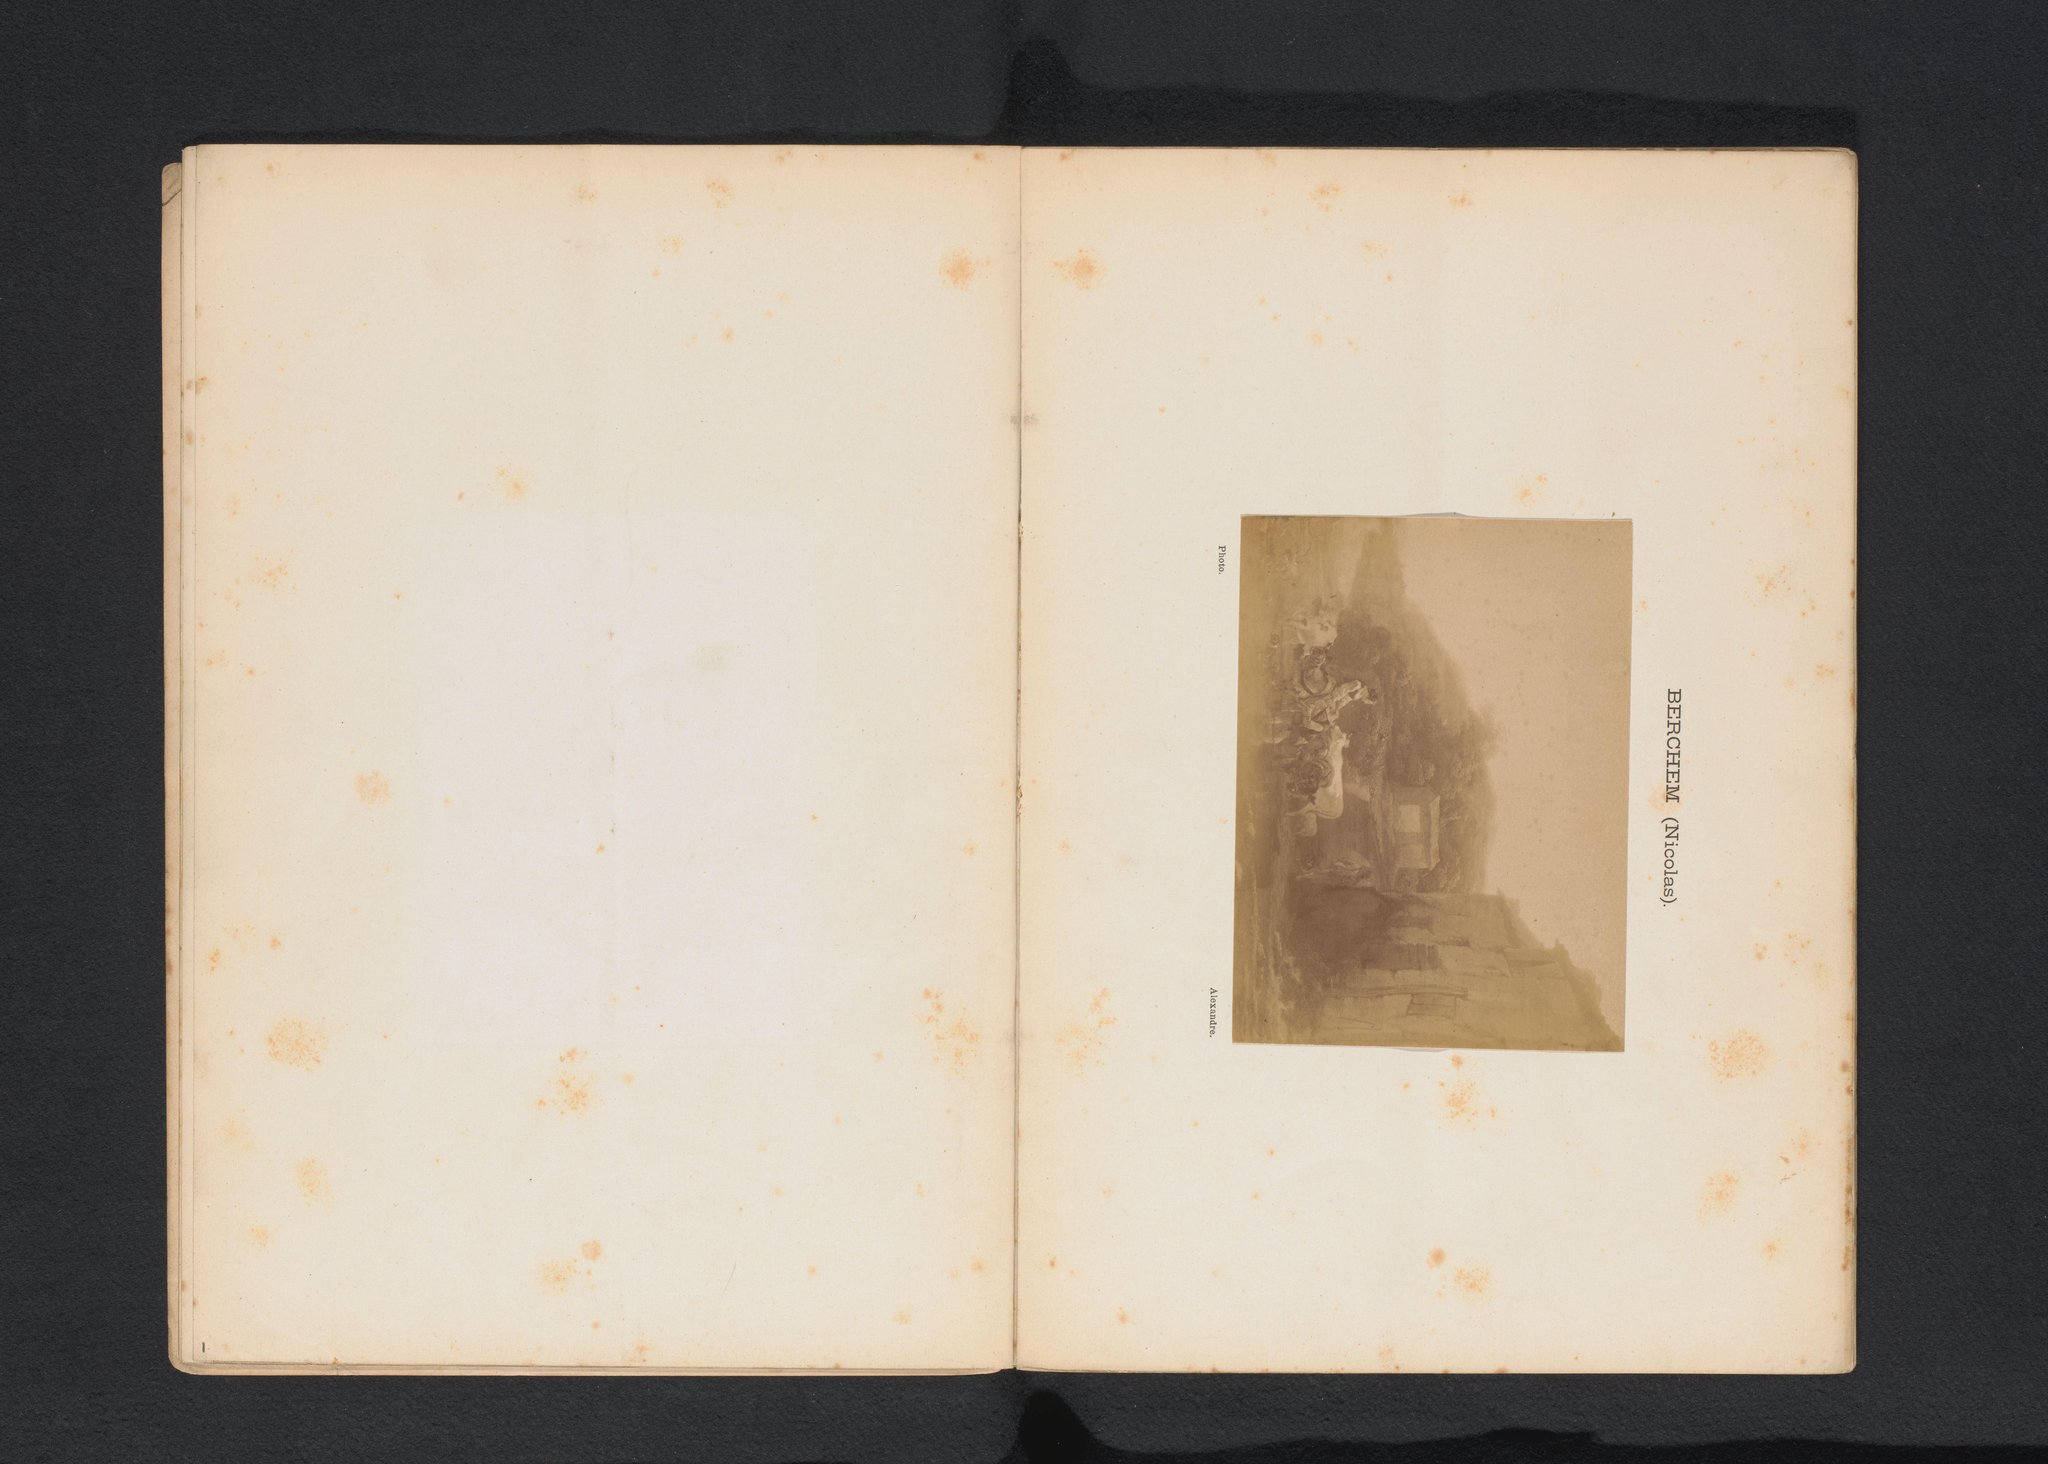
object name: page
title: Fotoreproductie van een schilderij van twee boeren en een vrouw bij een kudde dieren, door Nicolaes Pietersz. Berchem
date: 1886-1891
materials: photographic support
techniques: albumen print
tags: adult woman, cattle, farmers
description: Foto op derde ongenummerde pagina na pagina 8.